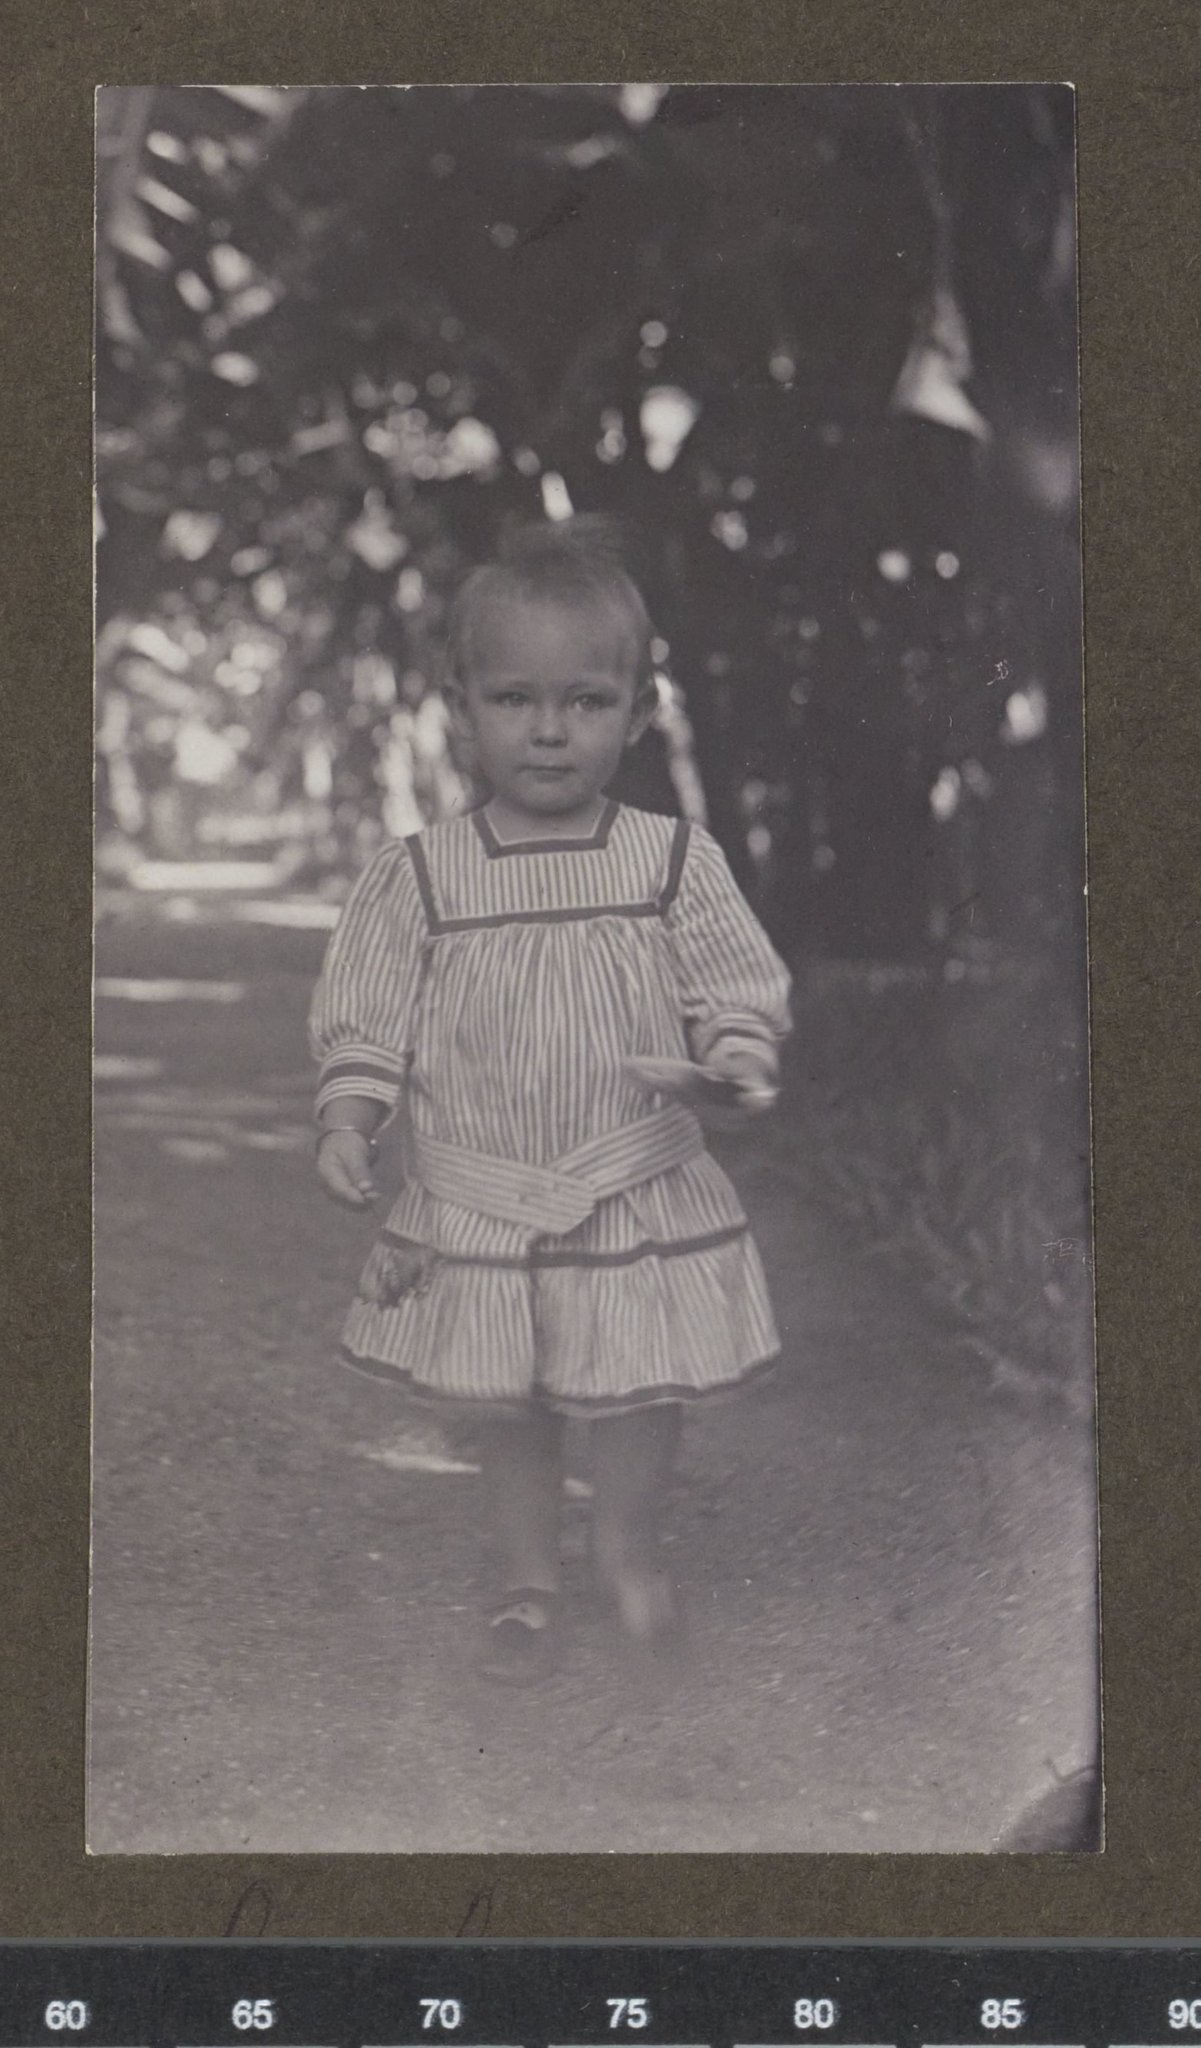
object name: photograph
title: Loulou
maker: Anonymous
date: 1910-1914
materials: photographic support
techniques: photography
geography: suriname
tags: suriname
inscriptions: inscription: ‘Loulou’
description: Een kind genaamd Loulou, lopend op een tuinpad. Onderdeel van een groep van elf albumbladen met familiefoto's van de familie Gonggrijp in Suriname, ca. 1912.